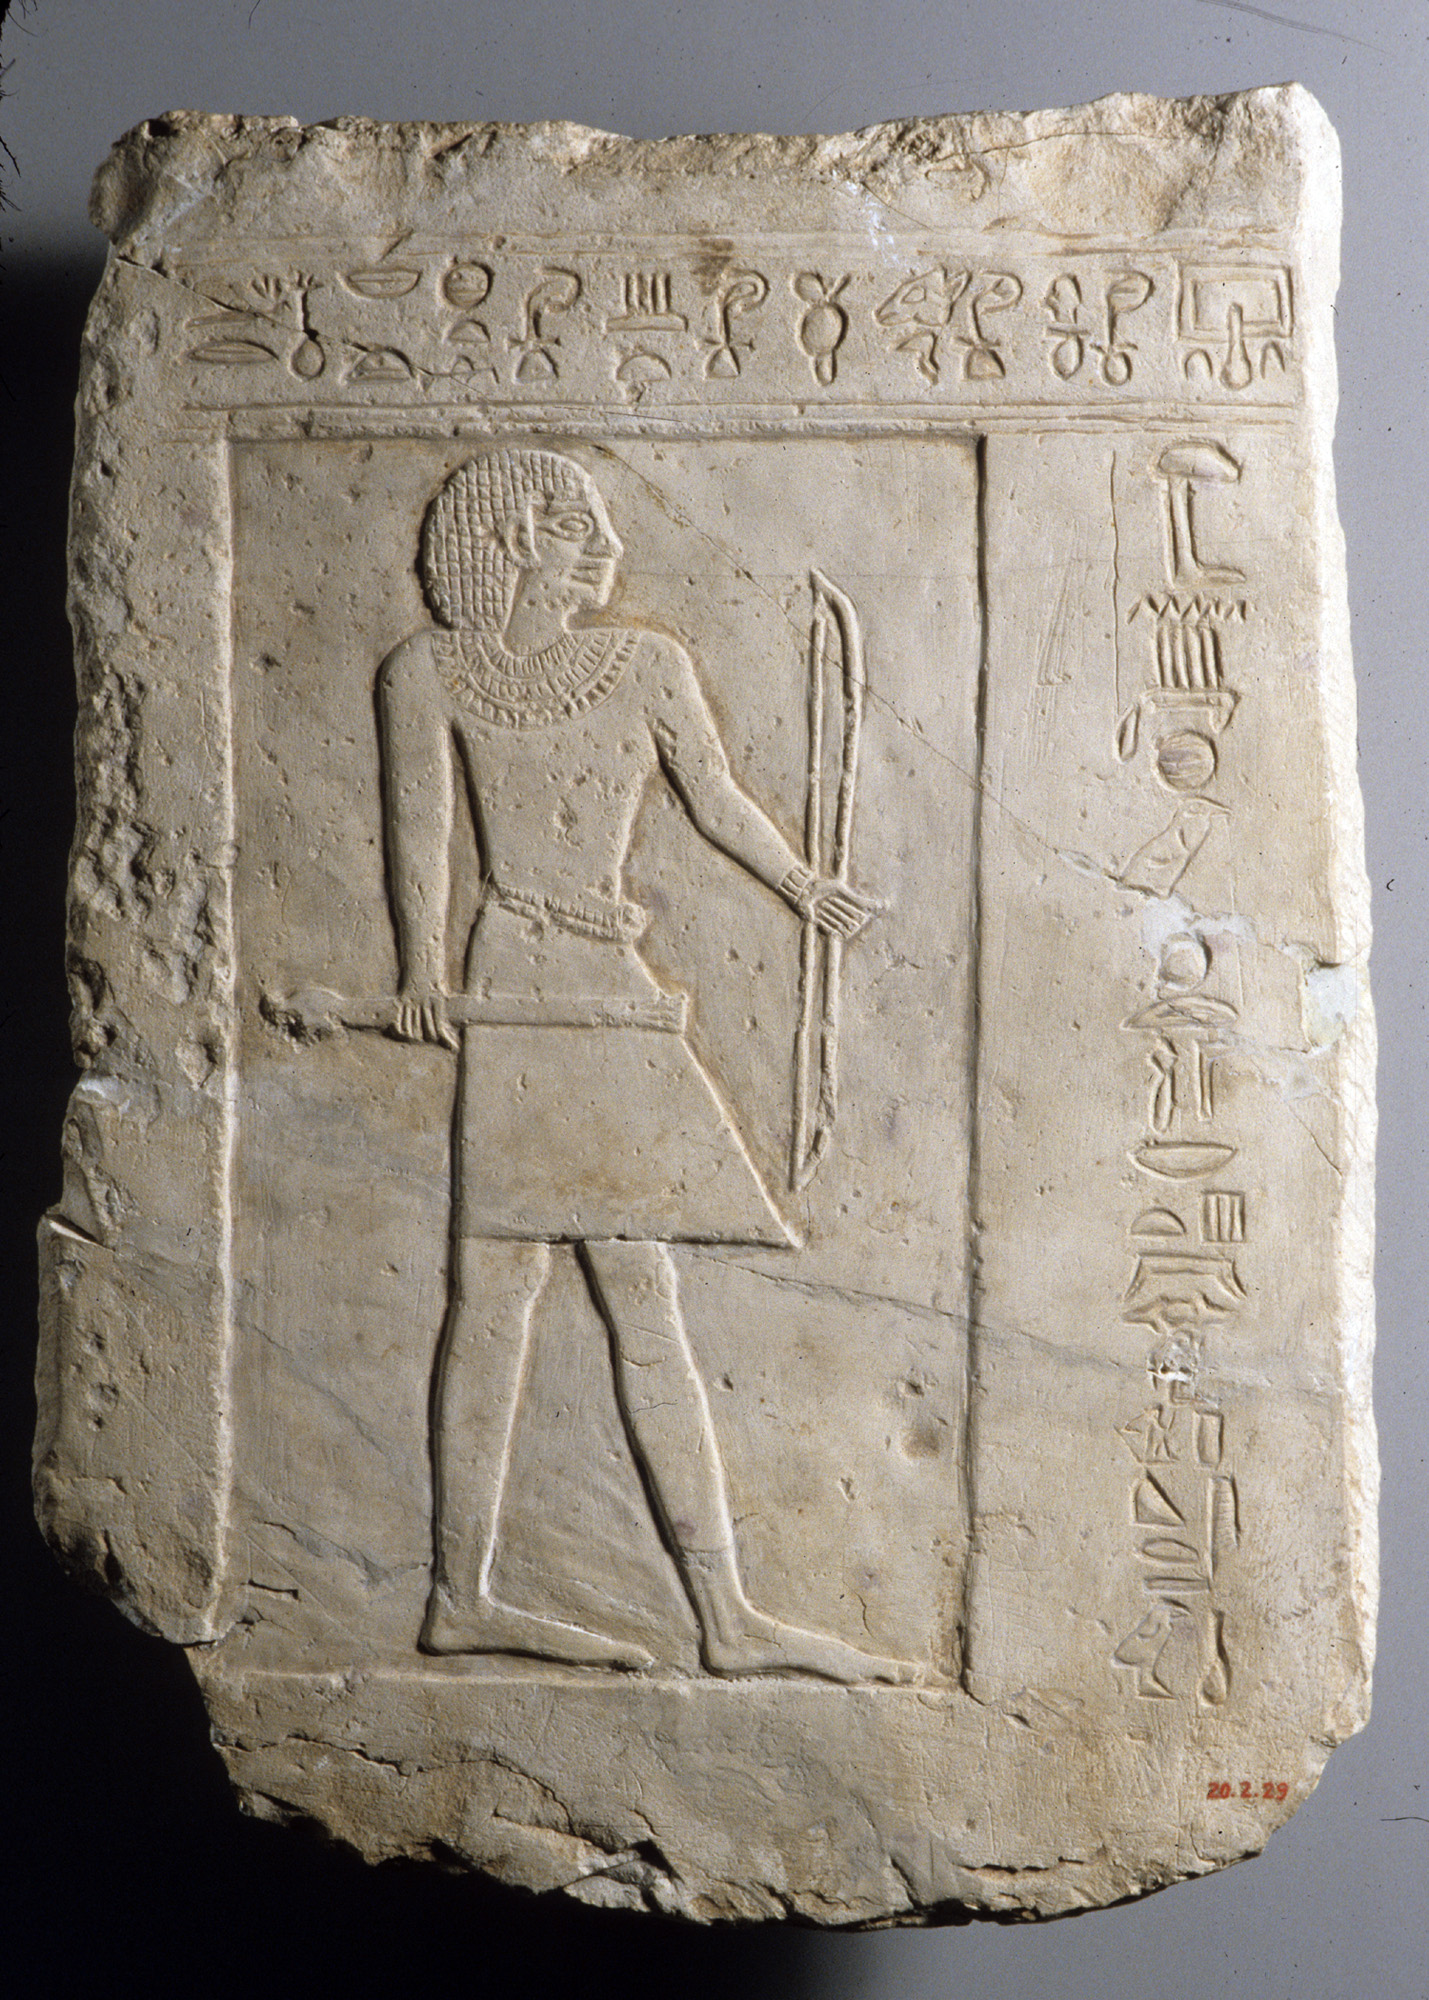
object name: stela, semin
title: Funerary stela of the bowman Semin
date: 2120-2051 BCE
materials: limestone, paint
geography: upper egypt, thebes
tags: bow and arrow,men,hieroglyphs